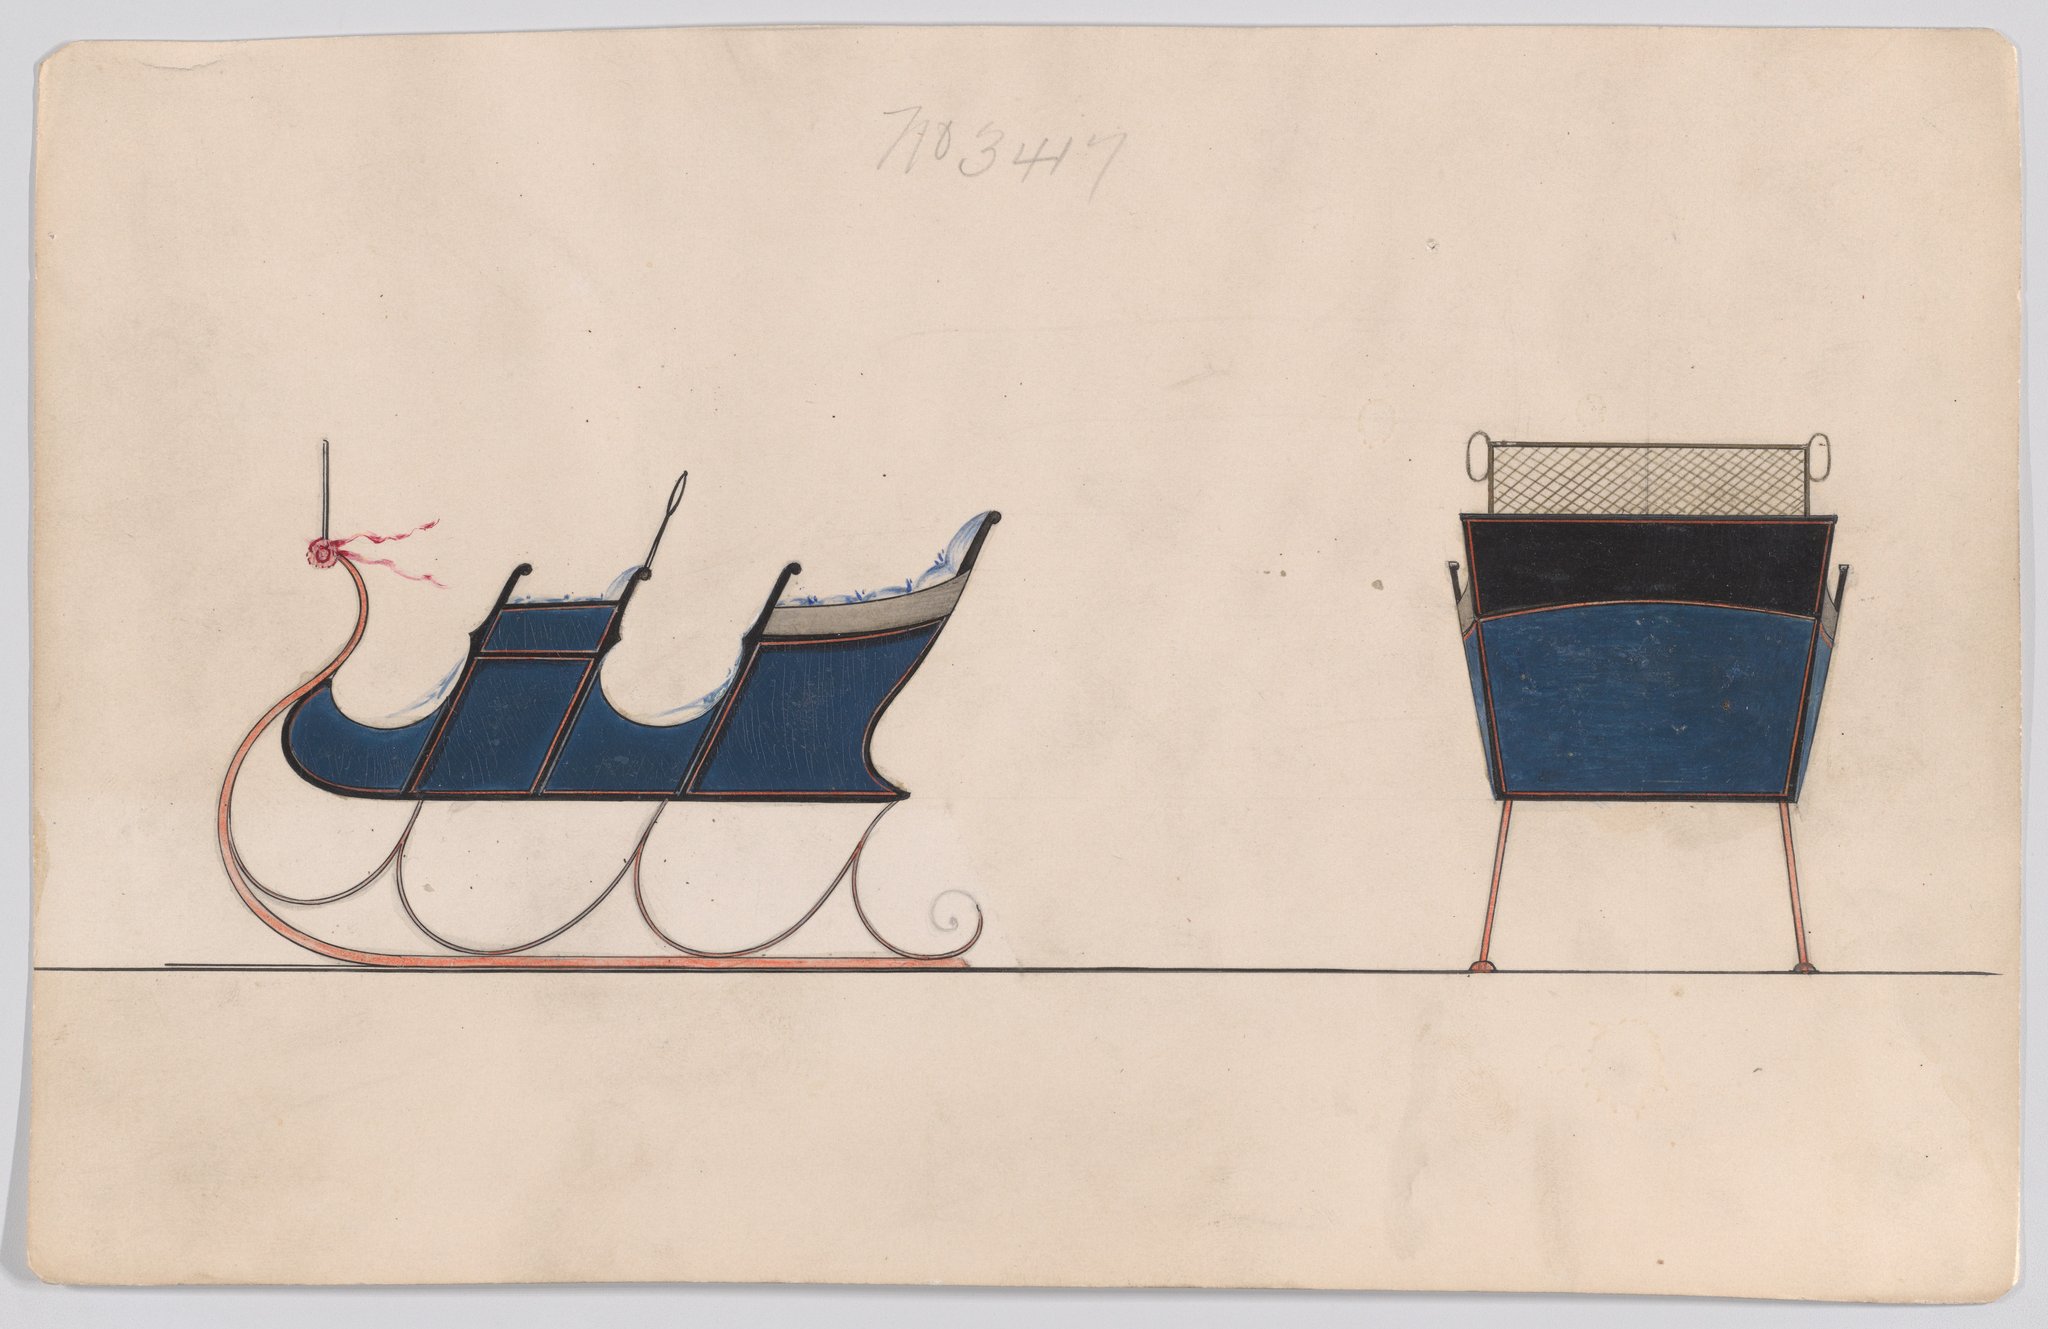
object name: drawing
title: Design for 2 Seat Sleigh, no. 3417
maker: brewster & co.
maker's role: manufacturer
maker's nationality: american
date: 1878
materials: gouache, ink, watercolor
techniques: pen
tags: sleighs